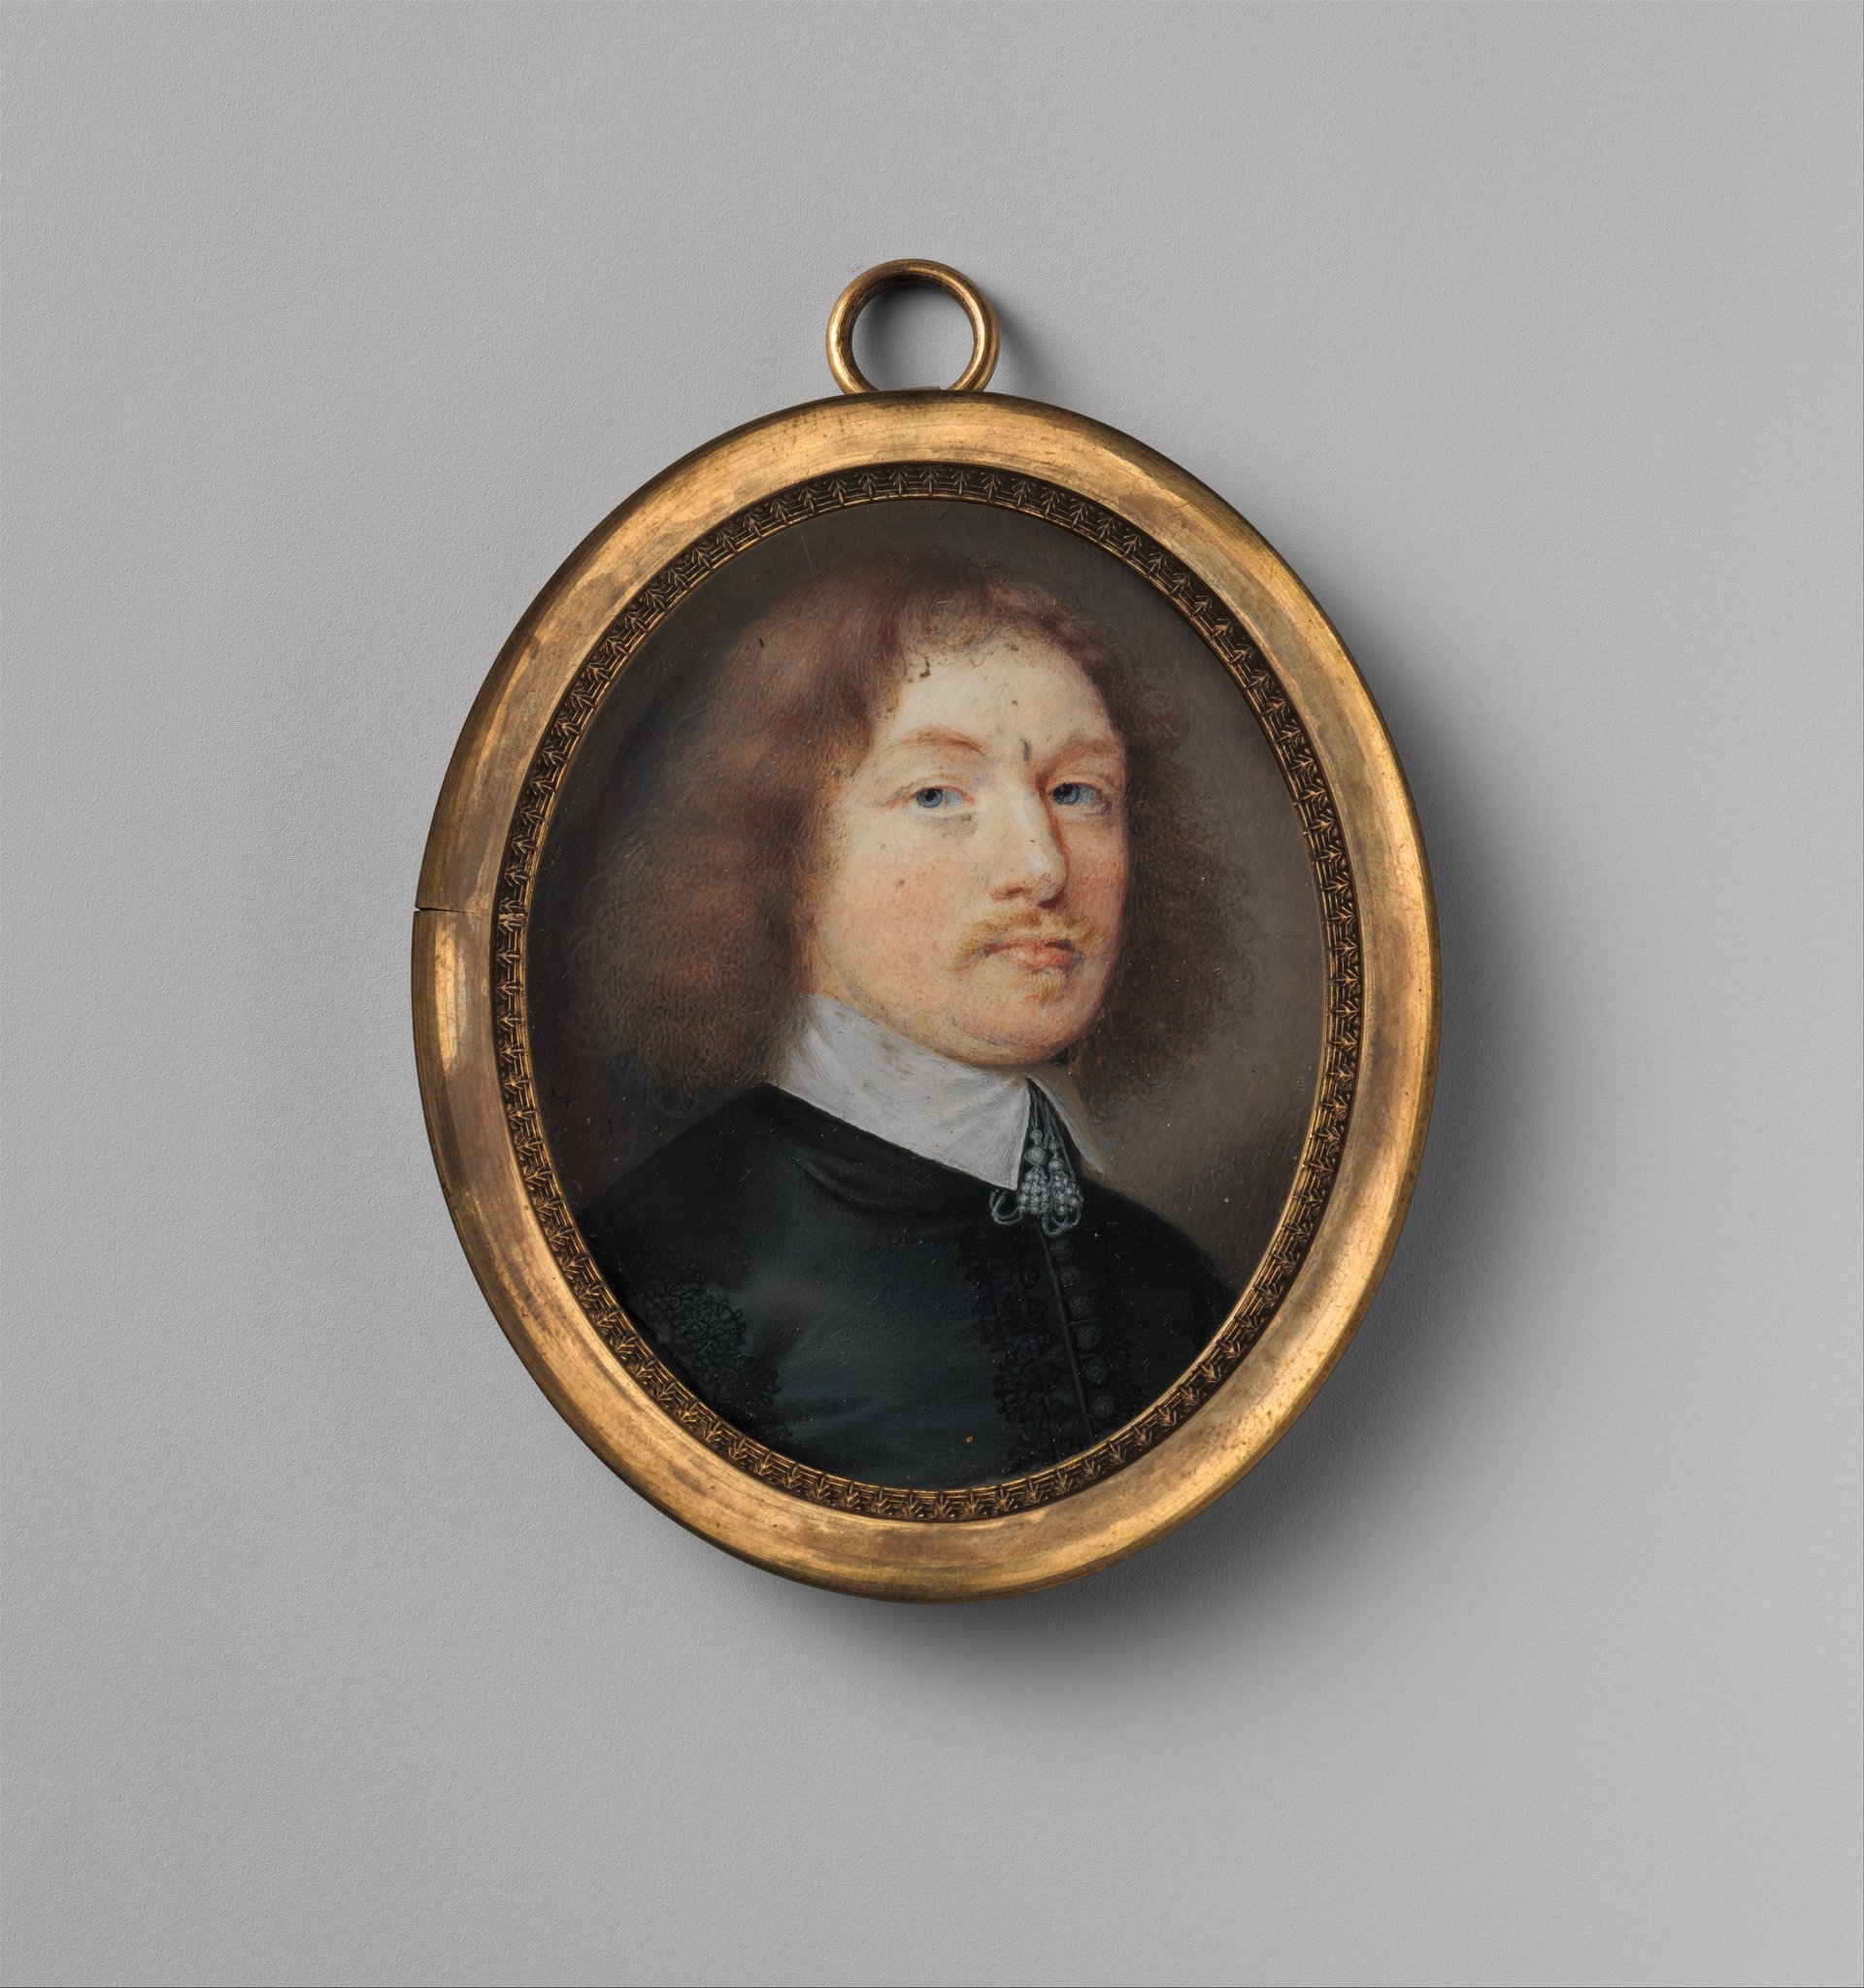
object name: painting, miniature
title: Portrait of a Man, Said to Be Philip Wharton (1613–1696), Fourth Baron Wharton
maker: john hoskins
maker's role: artist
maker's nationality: british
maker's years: 1615-1665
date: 1648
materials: parchment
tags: men,portraits